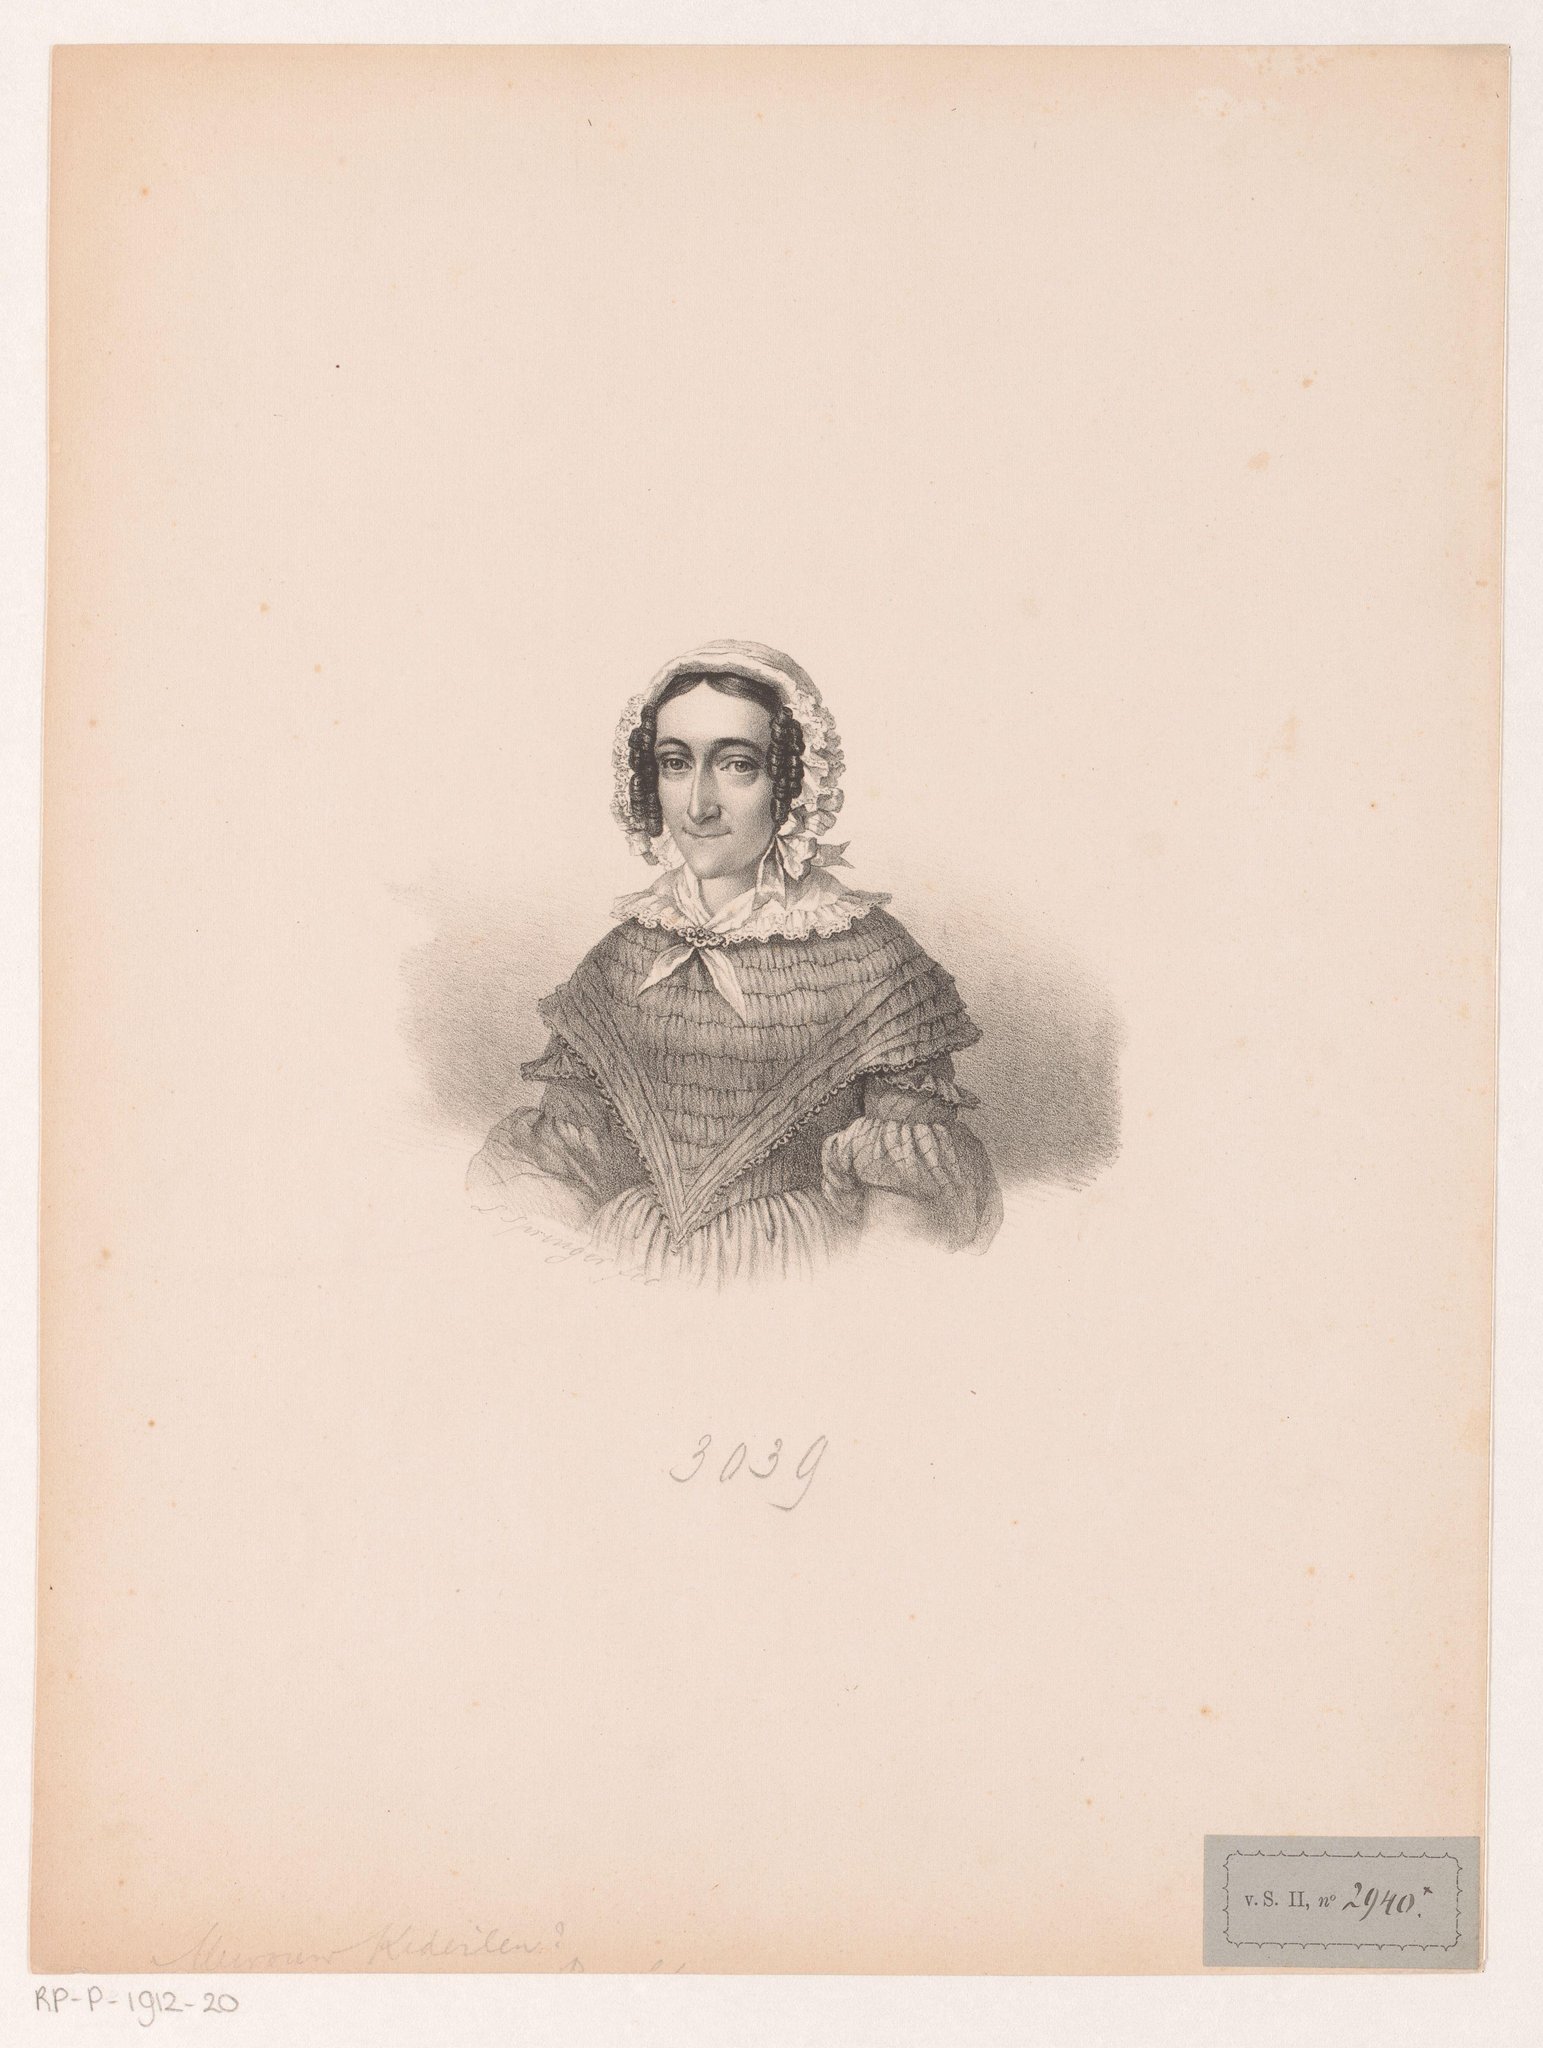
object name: print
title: Portret van onbekende vrouw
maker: leendert springer (i)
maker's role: draughtsman, painter, print maker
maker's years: 1789-1871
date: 1809-1871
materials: paper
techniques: lithograph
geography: leiden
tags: anonymous historical person portrayed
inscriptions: collector's mark: Lugt 2228